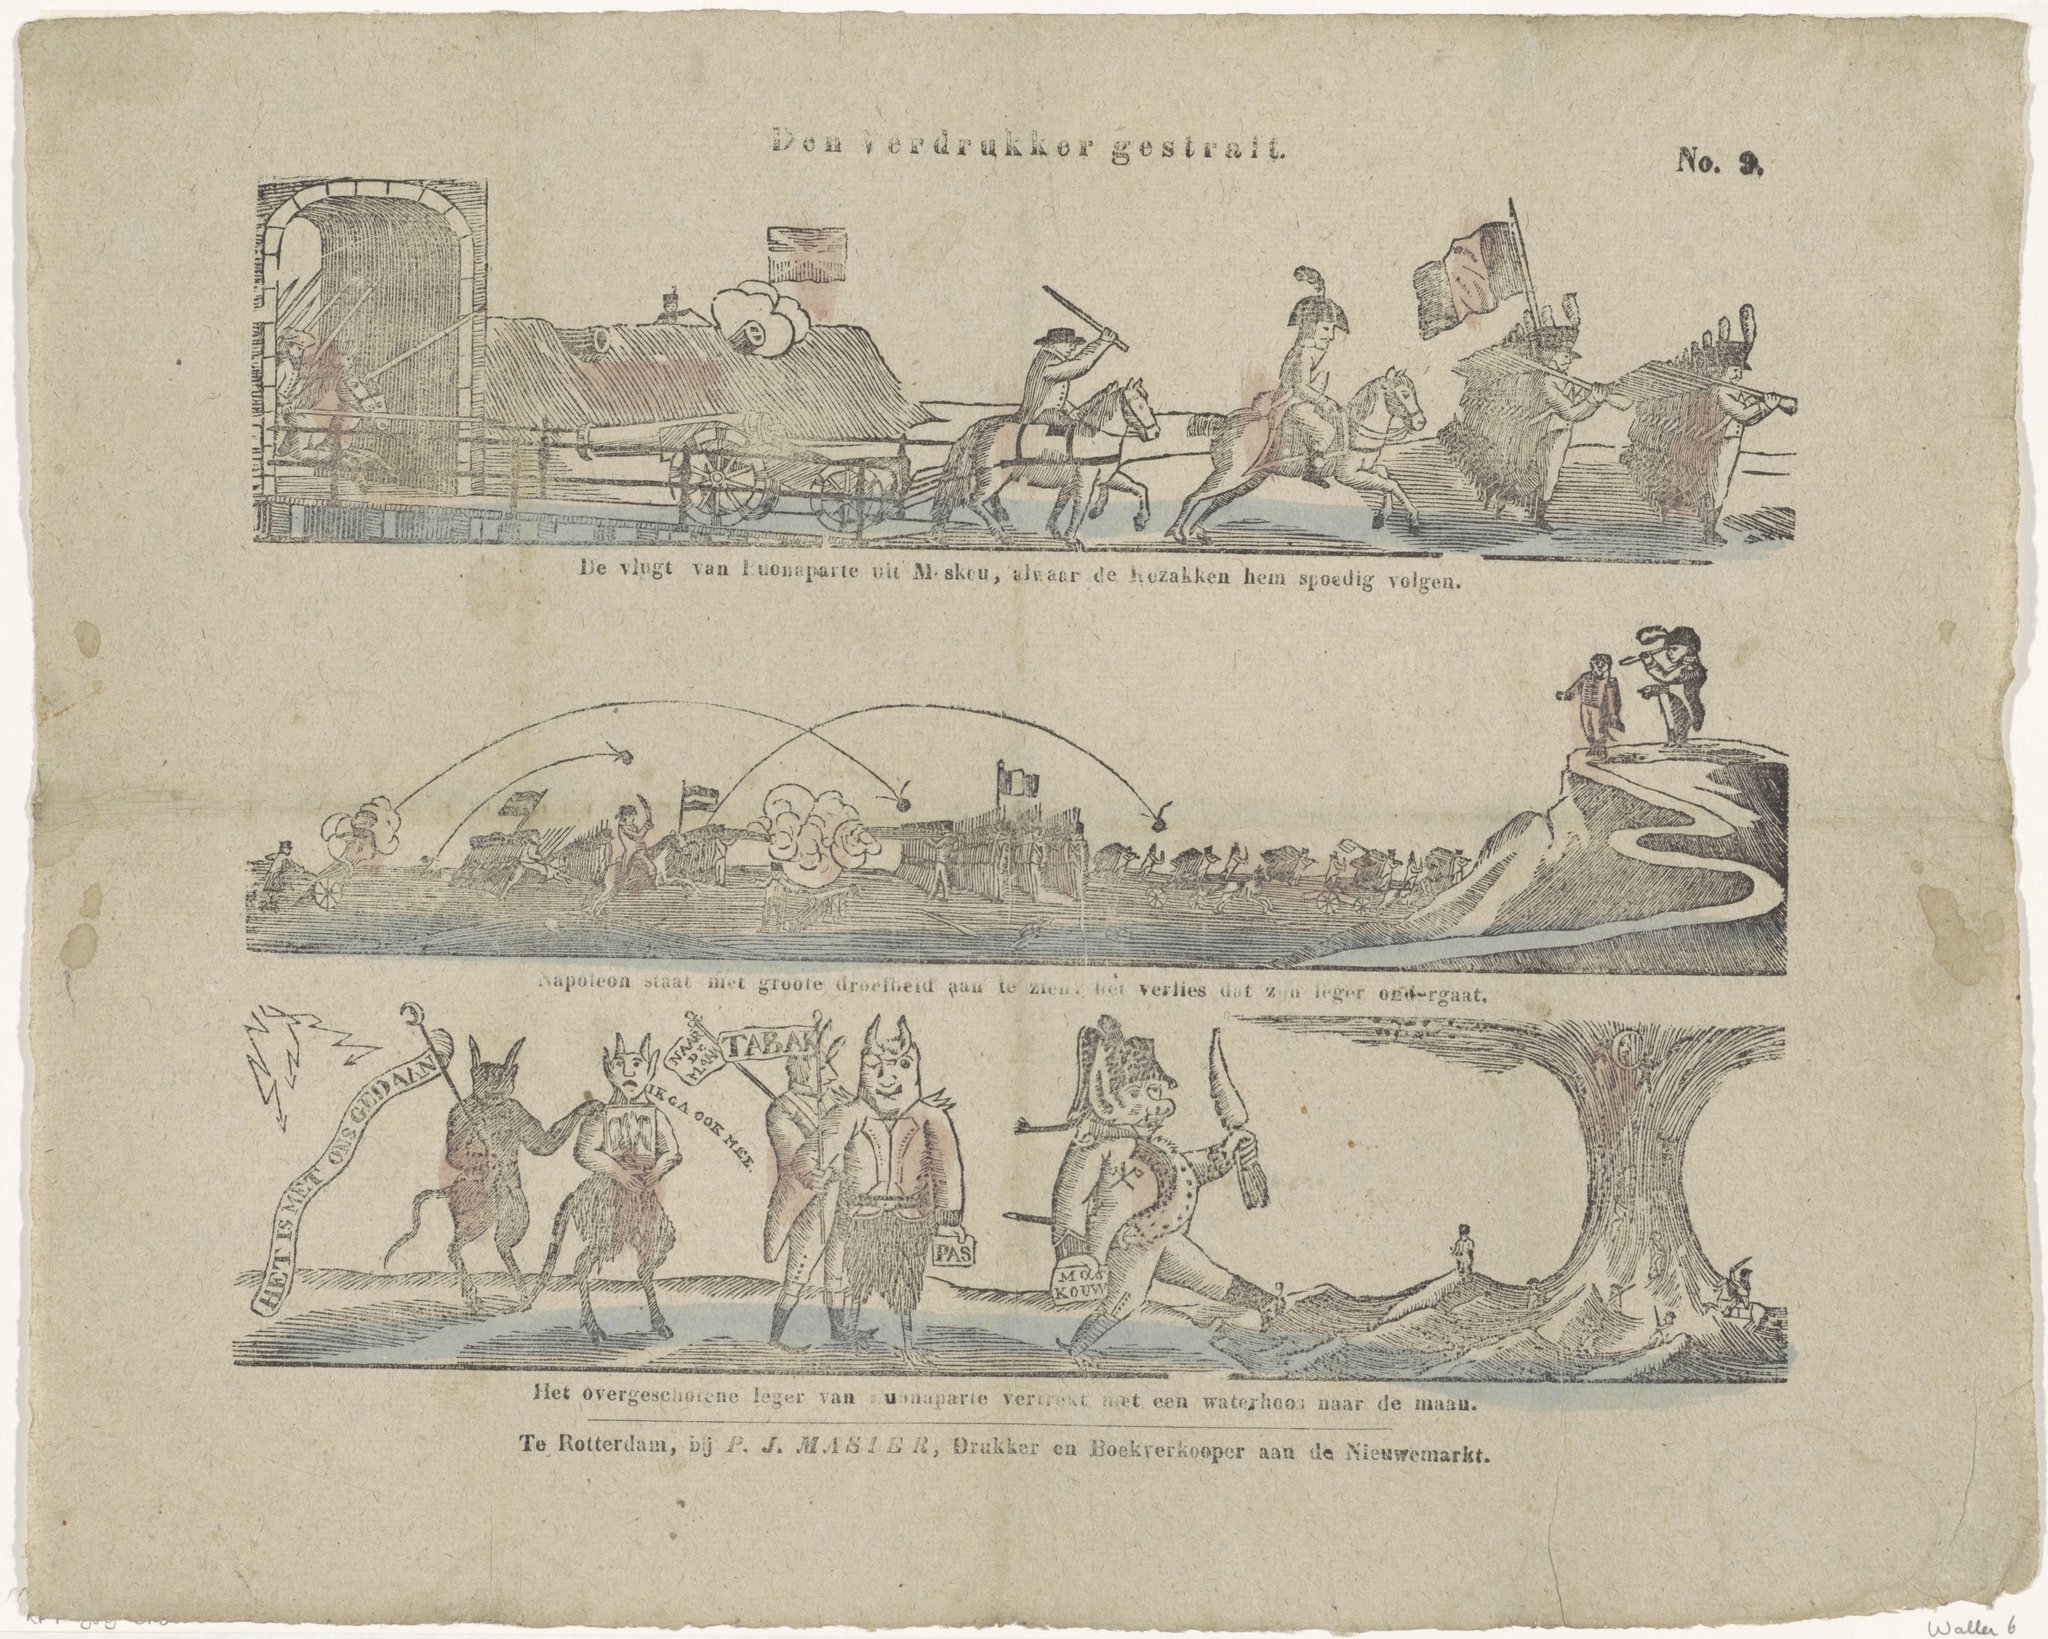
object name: print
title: Den verdrukker gestraft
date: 1827-1860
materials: paper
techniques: colour, letterpress printing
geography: rotterdam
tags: napoleon i (emperor of the french), political caricatures and satires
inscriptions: collector's mark: Lugt 2760, collector's mark: Lugt 2228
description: Blad met 3 horizontale rijen met voorstellingen over Napoleon, zoals Napoleon die met zijn leger uit Moskou vlucht, een strijd en Napoleon en zijn soldaten die in een waterhoos naar de maan gaan (spot). Onder elke afbeelding een onderschrift. Genummerd rechtsboven: No. 9.